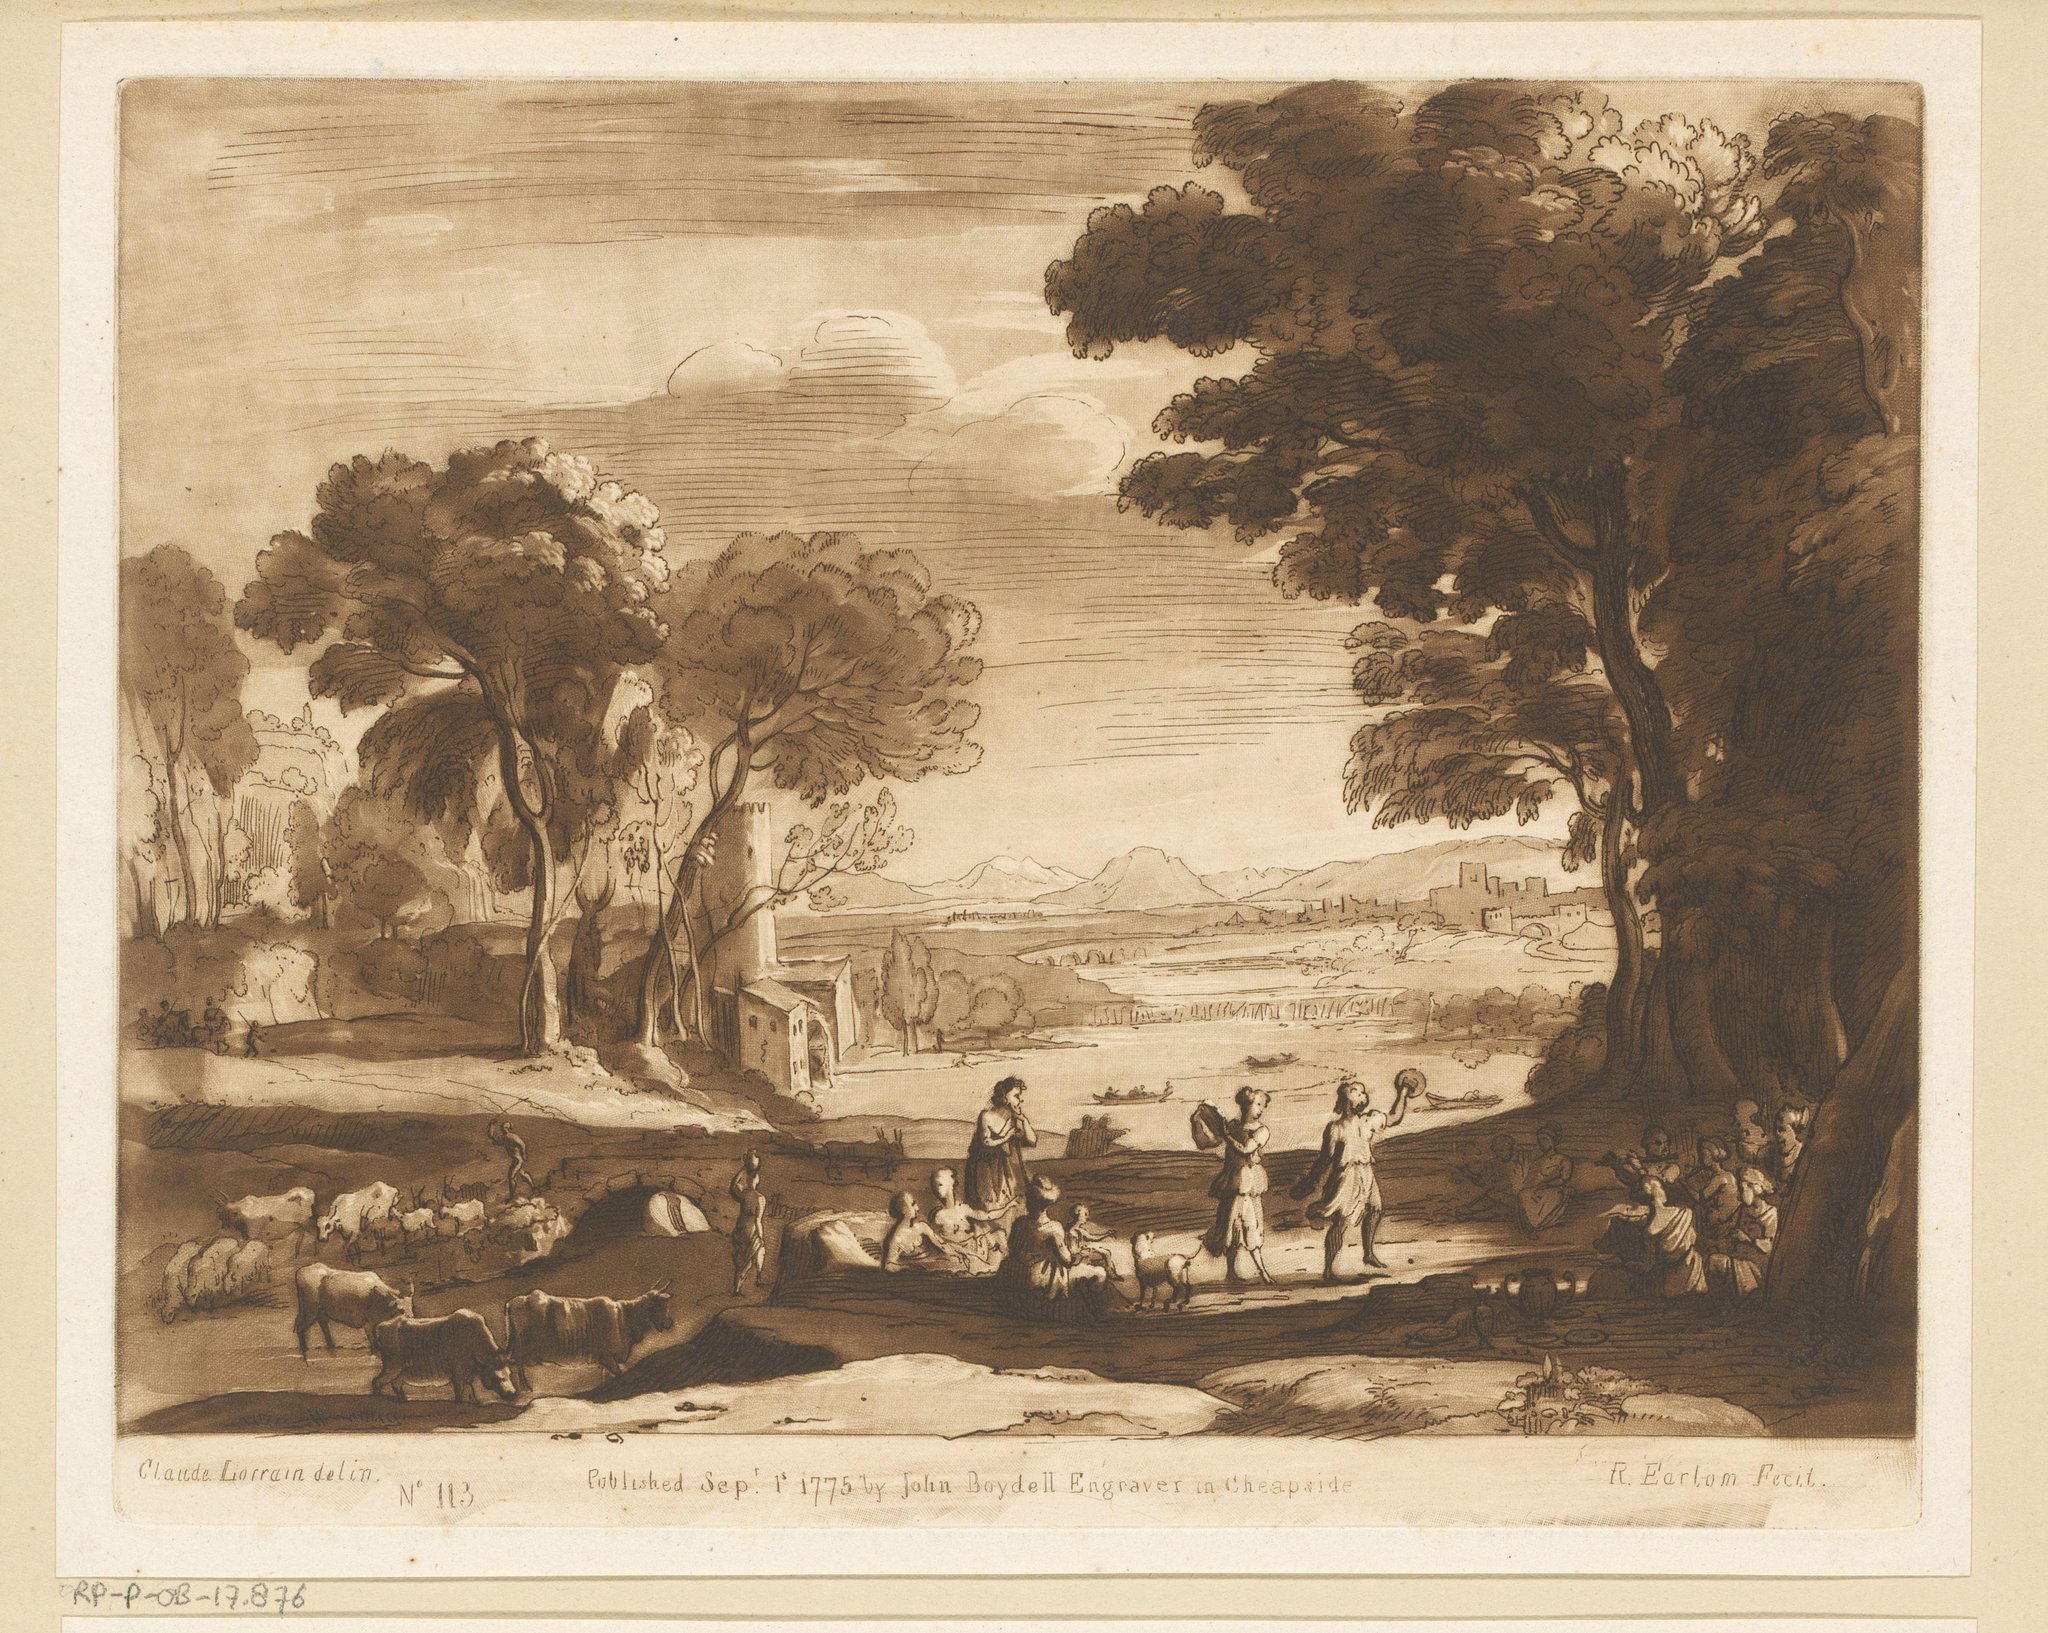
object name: print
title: Landschap met het huwelijk van Isaak en Rebekka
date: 1775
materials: paper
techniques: etching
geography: london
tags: river - hh - ideal landscapes, watermill in landscape - ii - ideal landscapes, one pair dancing; man and woman dancing as a couple, making music; musician with instrument - cc - out of doors, marriage of isaac and rebekah, pastorals, arcadian scenes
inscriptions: date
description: Vanaf 1774 publiceerde John Boydell tweehonderd prenten naar het tekeningenboek Liber Veritatis van Claude Lorrain, in het bezit van de hertogen van Cavendish. Deze prenten werden vanaf 1777 in twee volumes gebundeld uitgegeven.